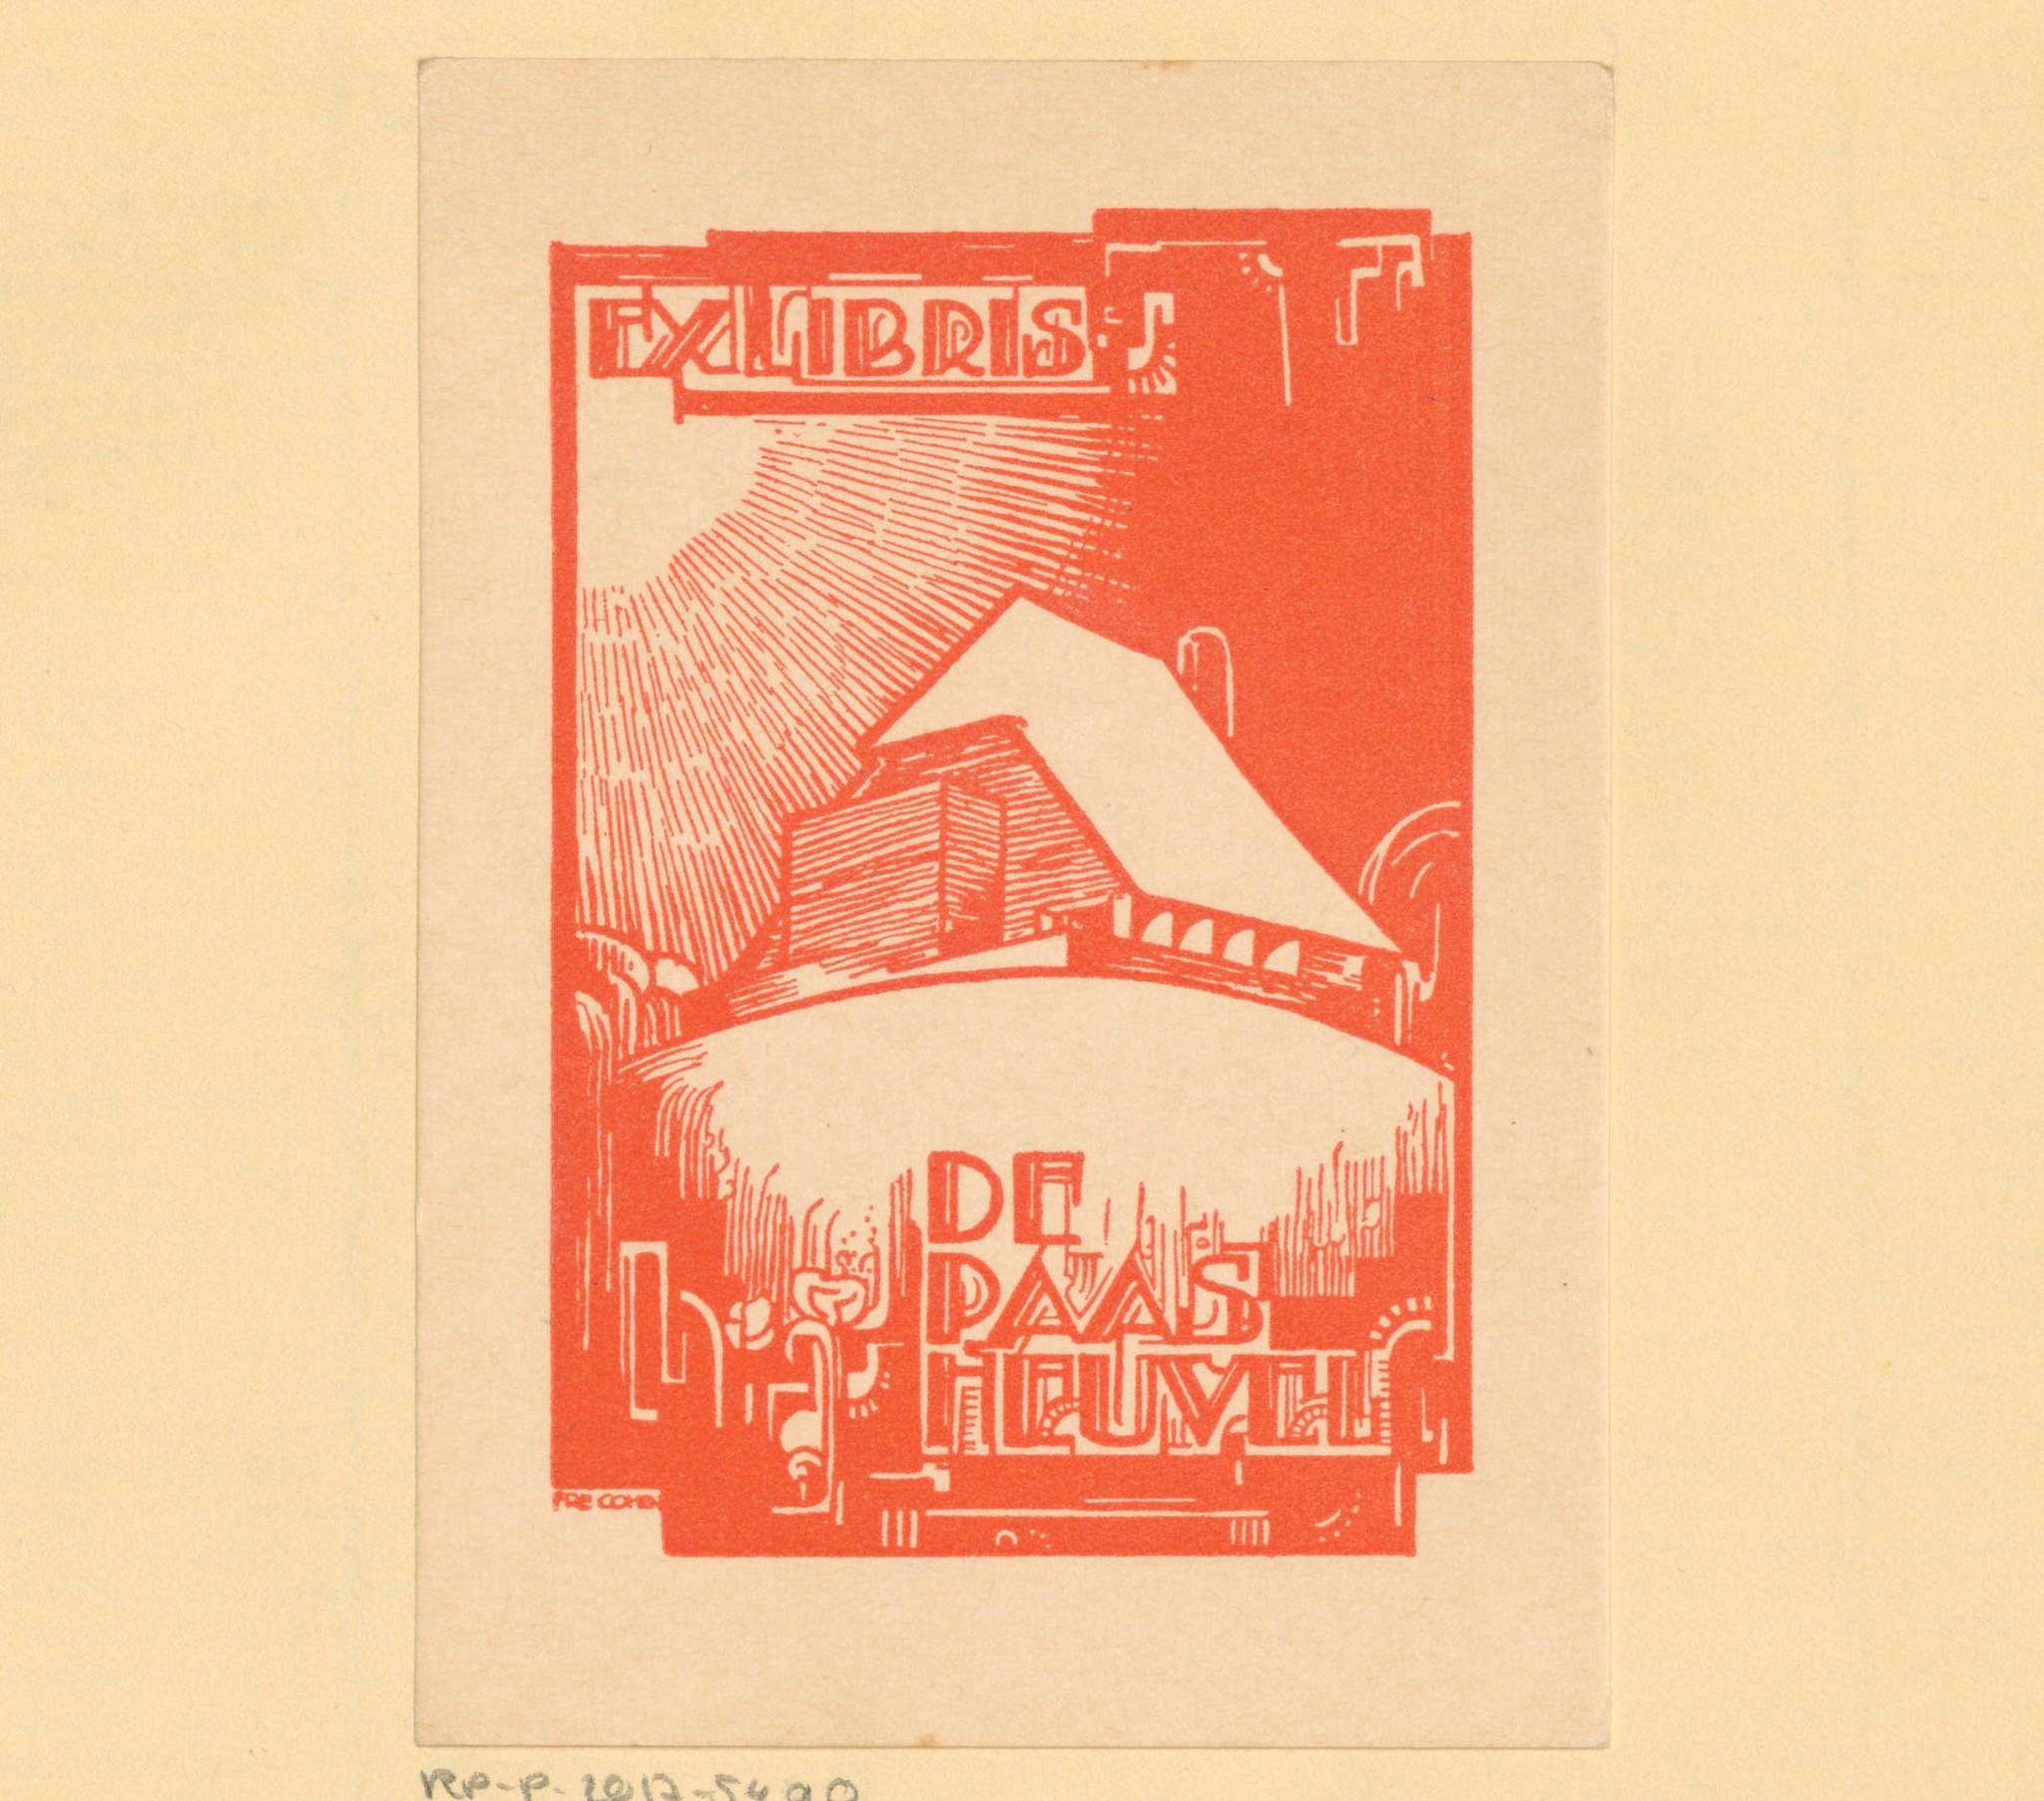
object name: bookplate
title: Ex libris van de Paasheuvel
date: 1923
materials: paper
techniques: printing block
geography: netherlands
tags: cottage, sun as celestial body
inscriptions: inscription: ‘1923, eerste cl.’